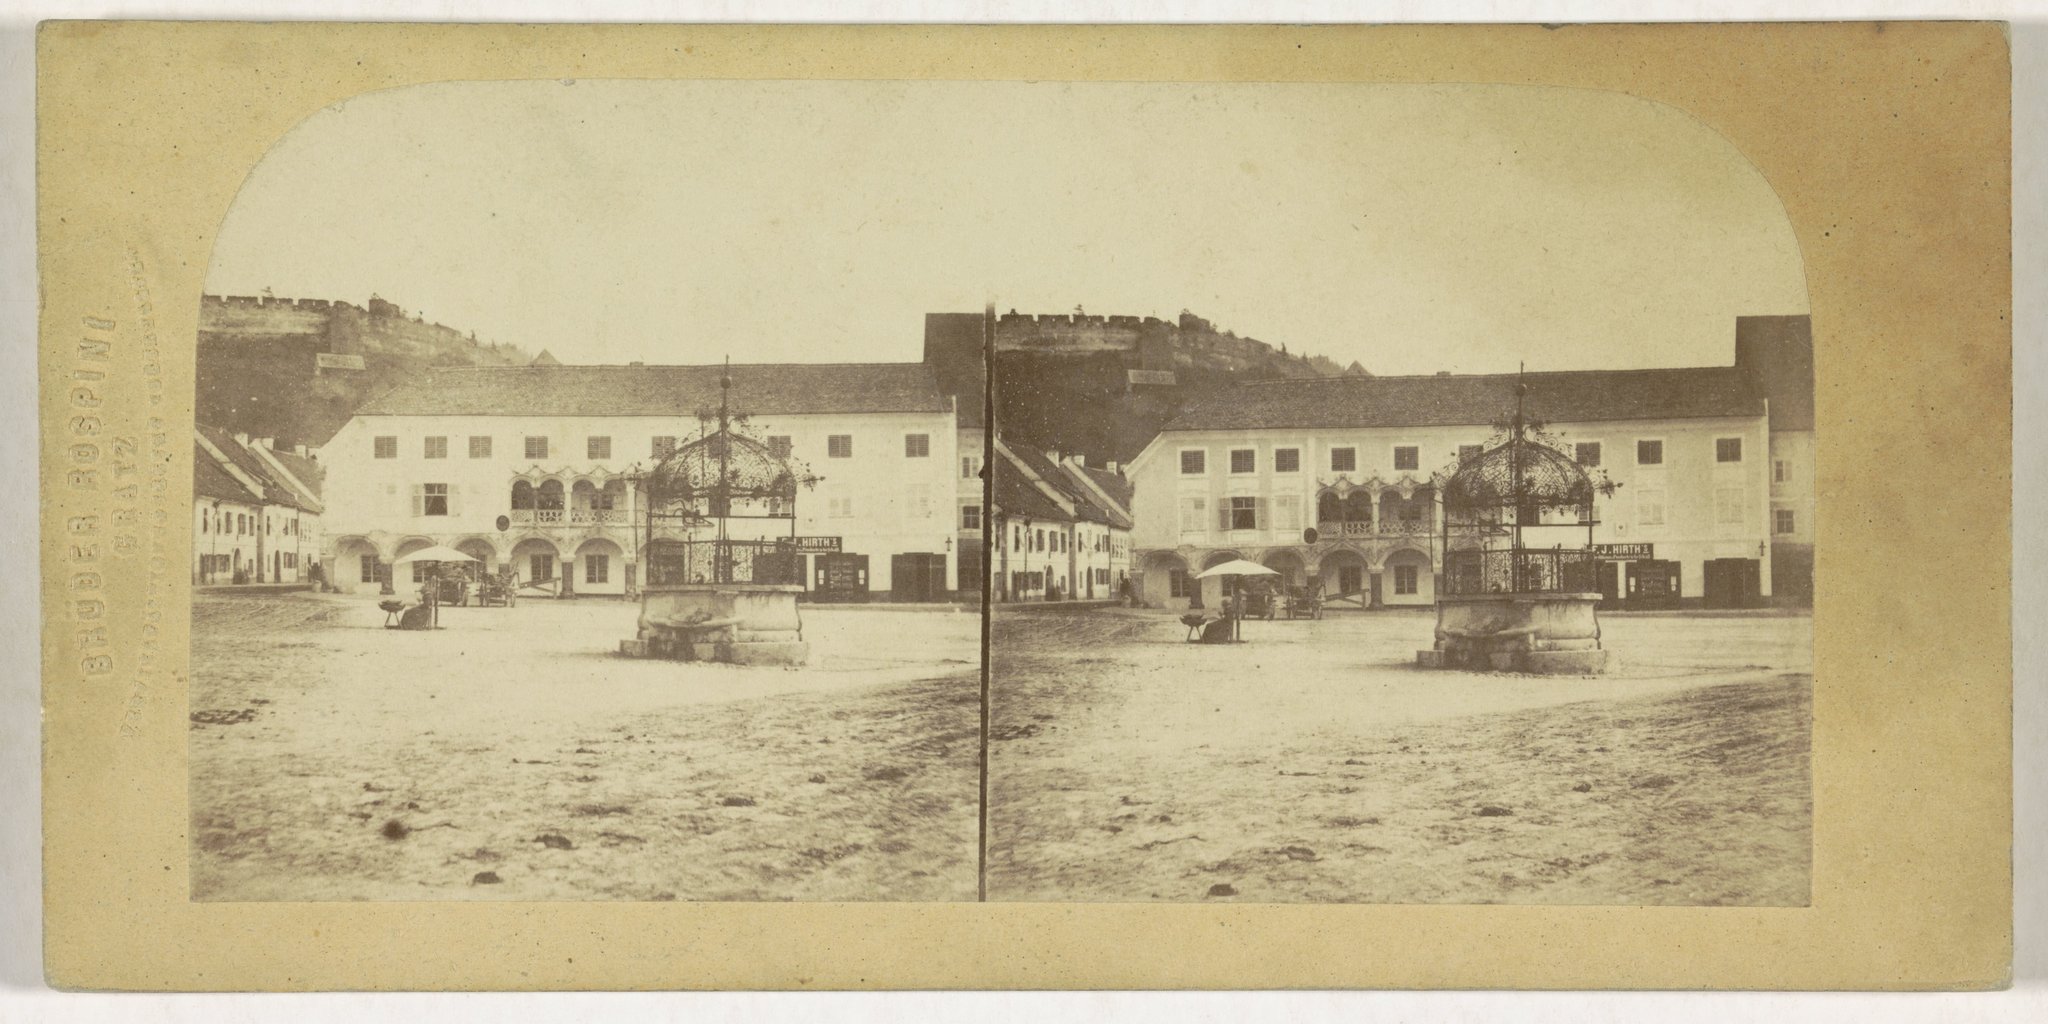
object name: stereograph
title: Hauptplatz met de Eiserner Brunnen in Bruck an der Mur, Oostenrijk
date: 1857-1863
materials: cardboard, paper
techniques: albumen print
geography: bruck an der mur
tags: well, square, place, circus, etc.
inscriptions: inscription: ‘Vervielfältigungsrecht vorbehalten’, inscription: ‘Oostenrijk’, number: ‘79.’